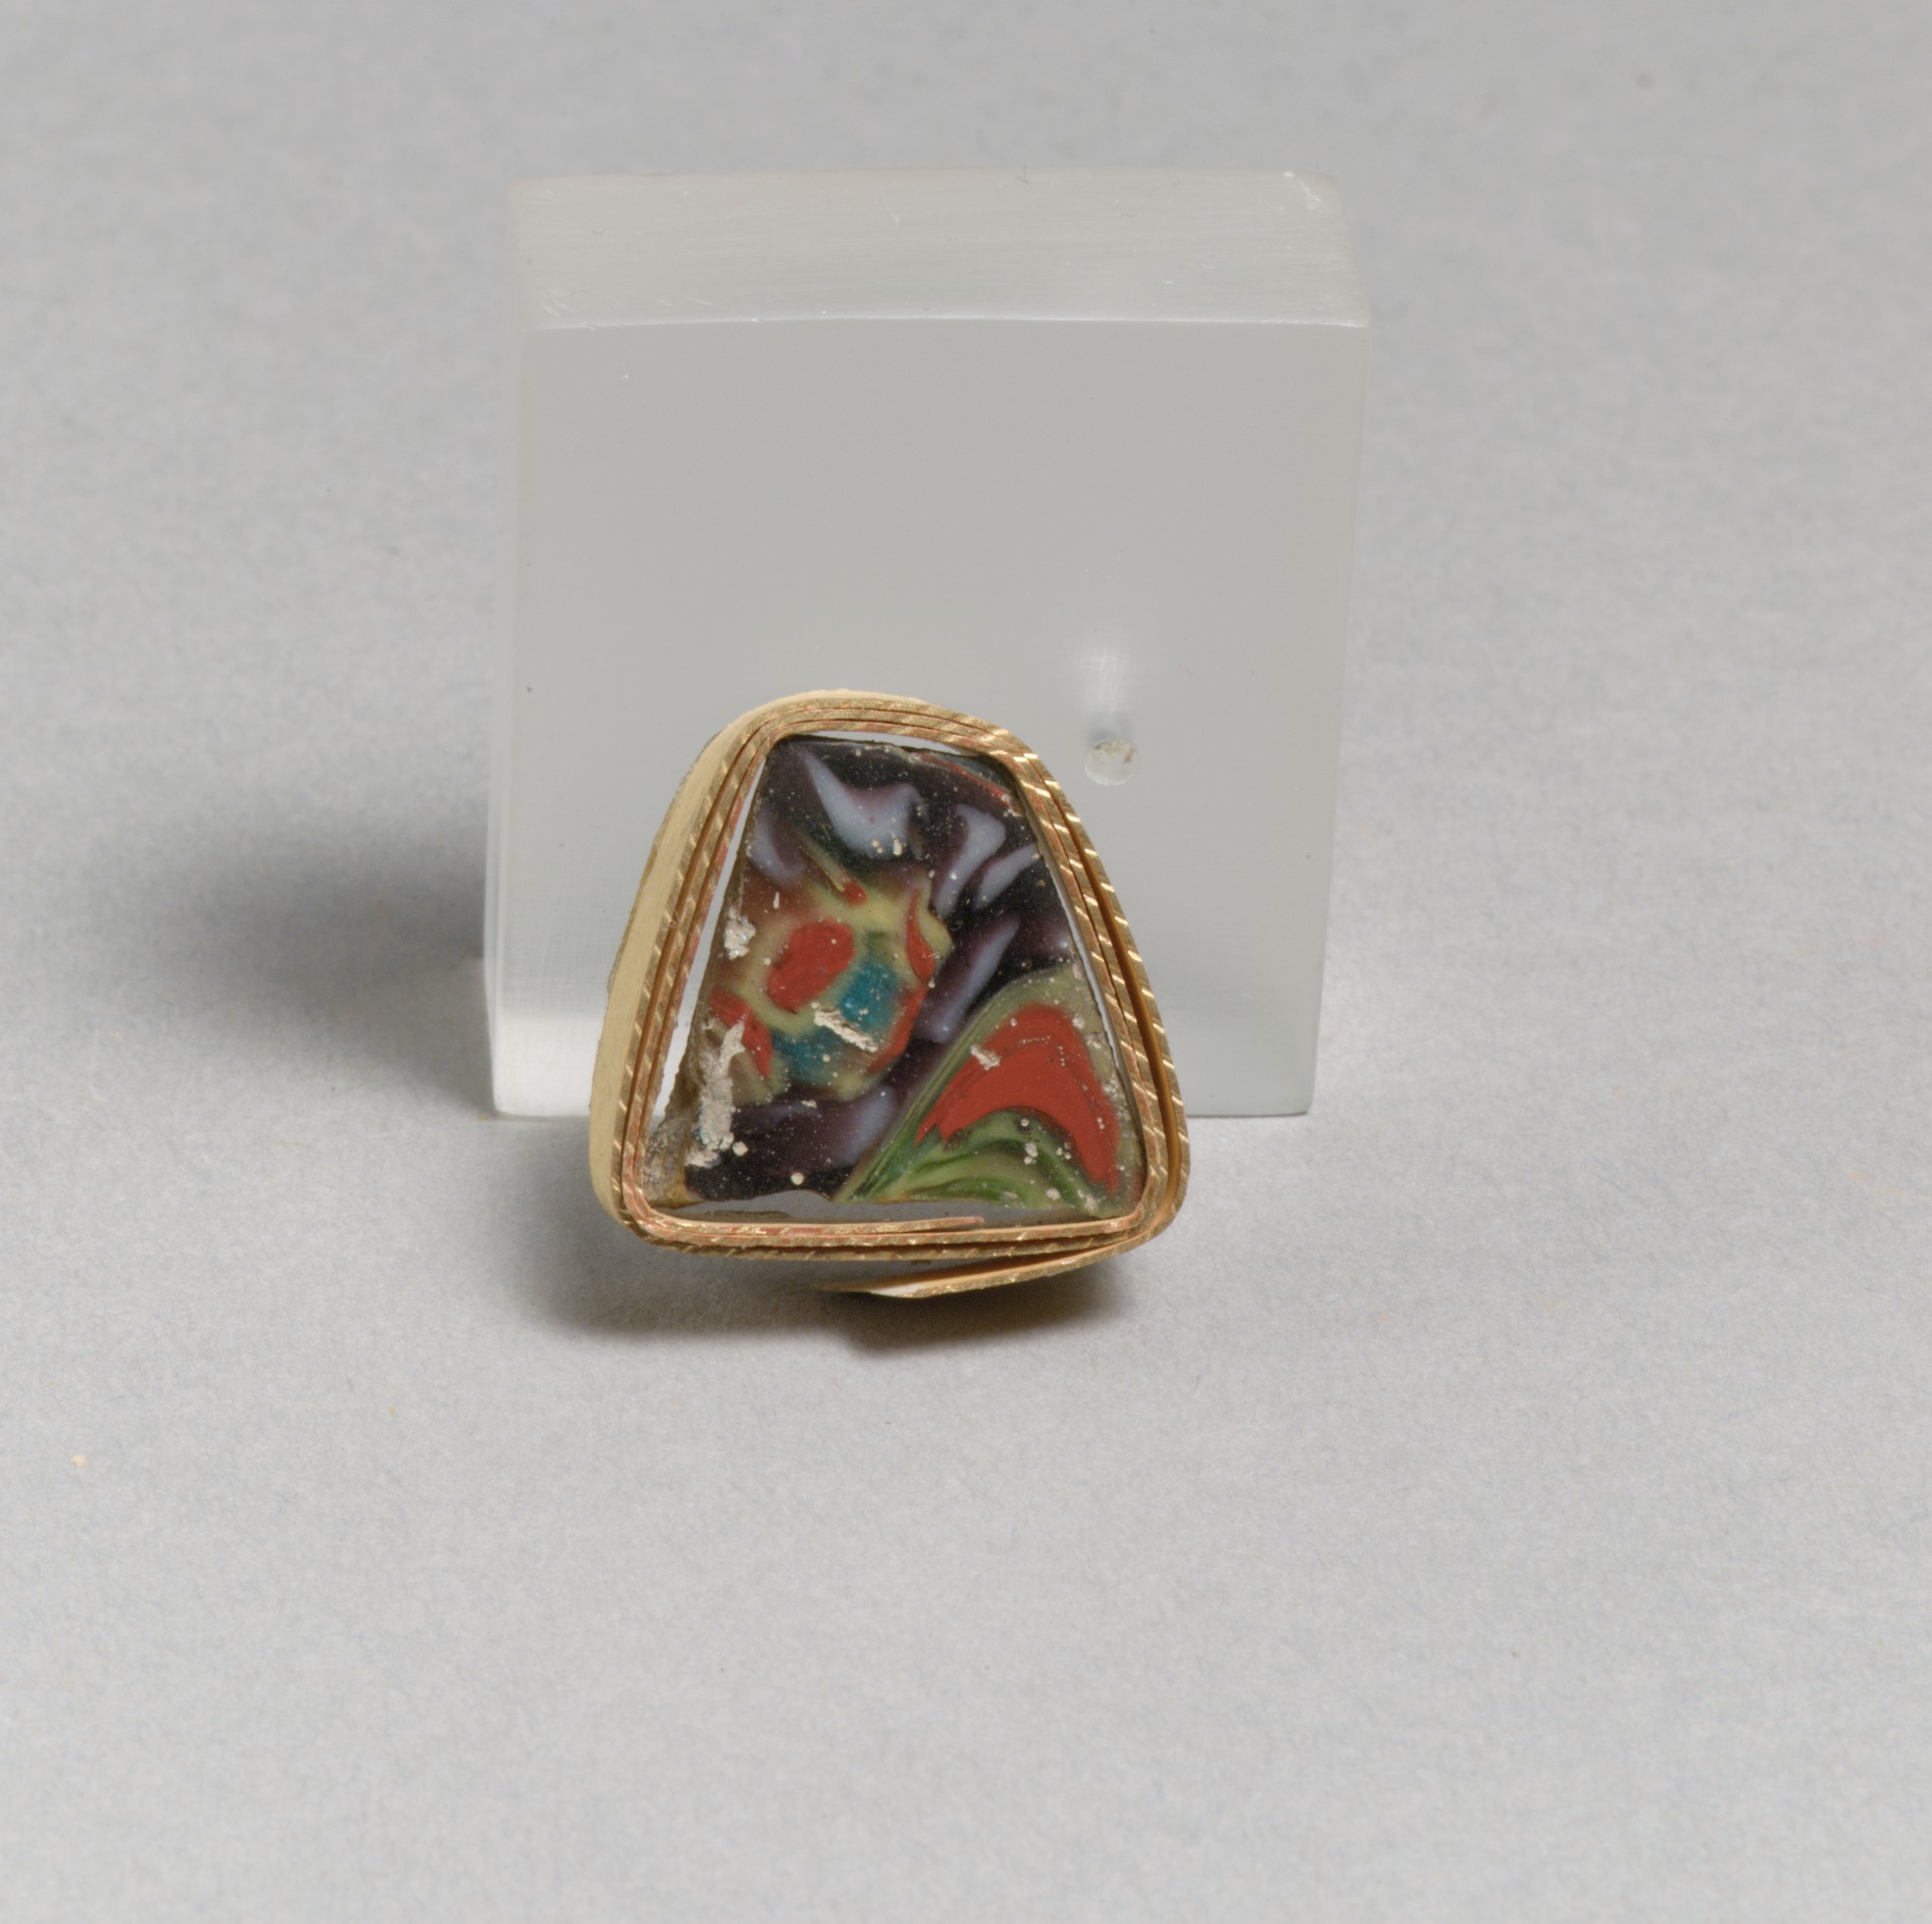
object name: fragment, mosaic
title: Glass mosaic fragment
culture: roman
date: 34 BCE-33 CE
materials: glass